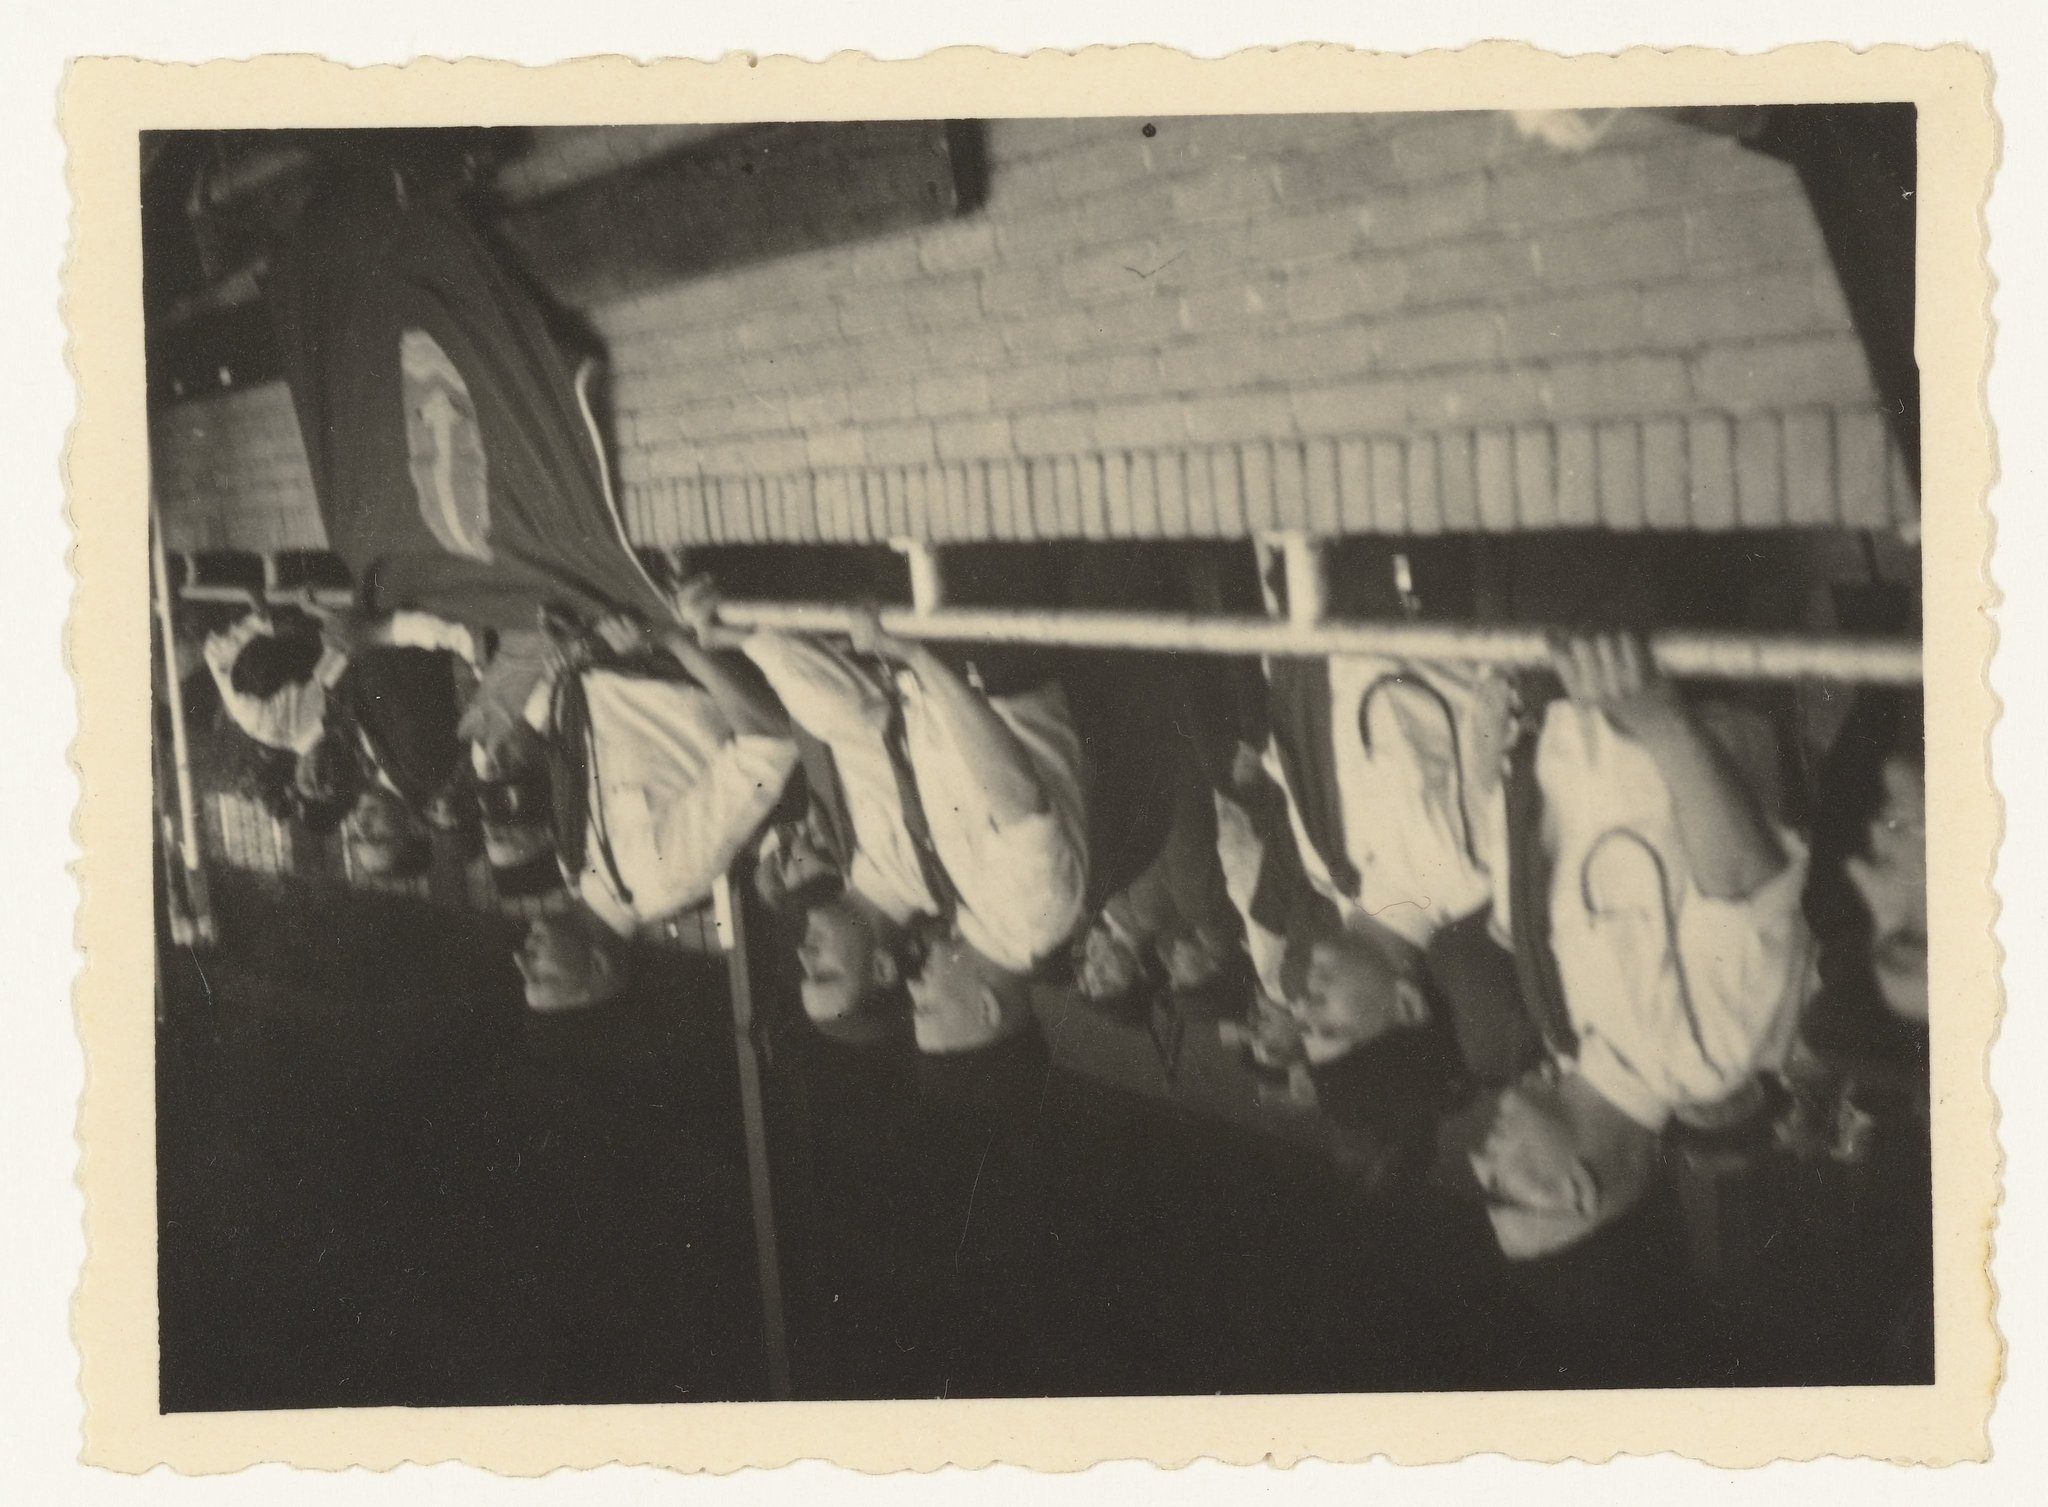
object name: photograph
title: Jeugdstorm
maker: Anonymous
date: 1934-1940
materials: photographic support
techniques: photography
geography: netherlands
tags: netherlands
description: Groep leiders van de Jeugdstorm in uniform staan achter een laag muurtje, vermoedelijk in een stadion. Vierde van links is de leider van de Jeugdstorm C. van Geelkerken. Over het muurtje hangt de vlag van de Jeugdstorm. Achter hen staan nog meer mensen.